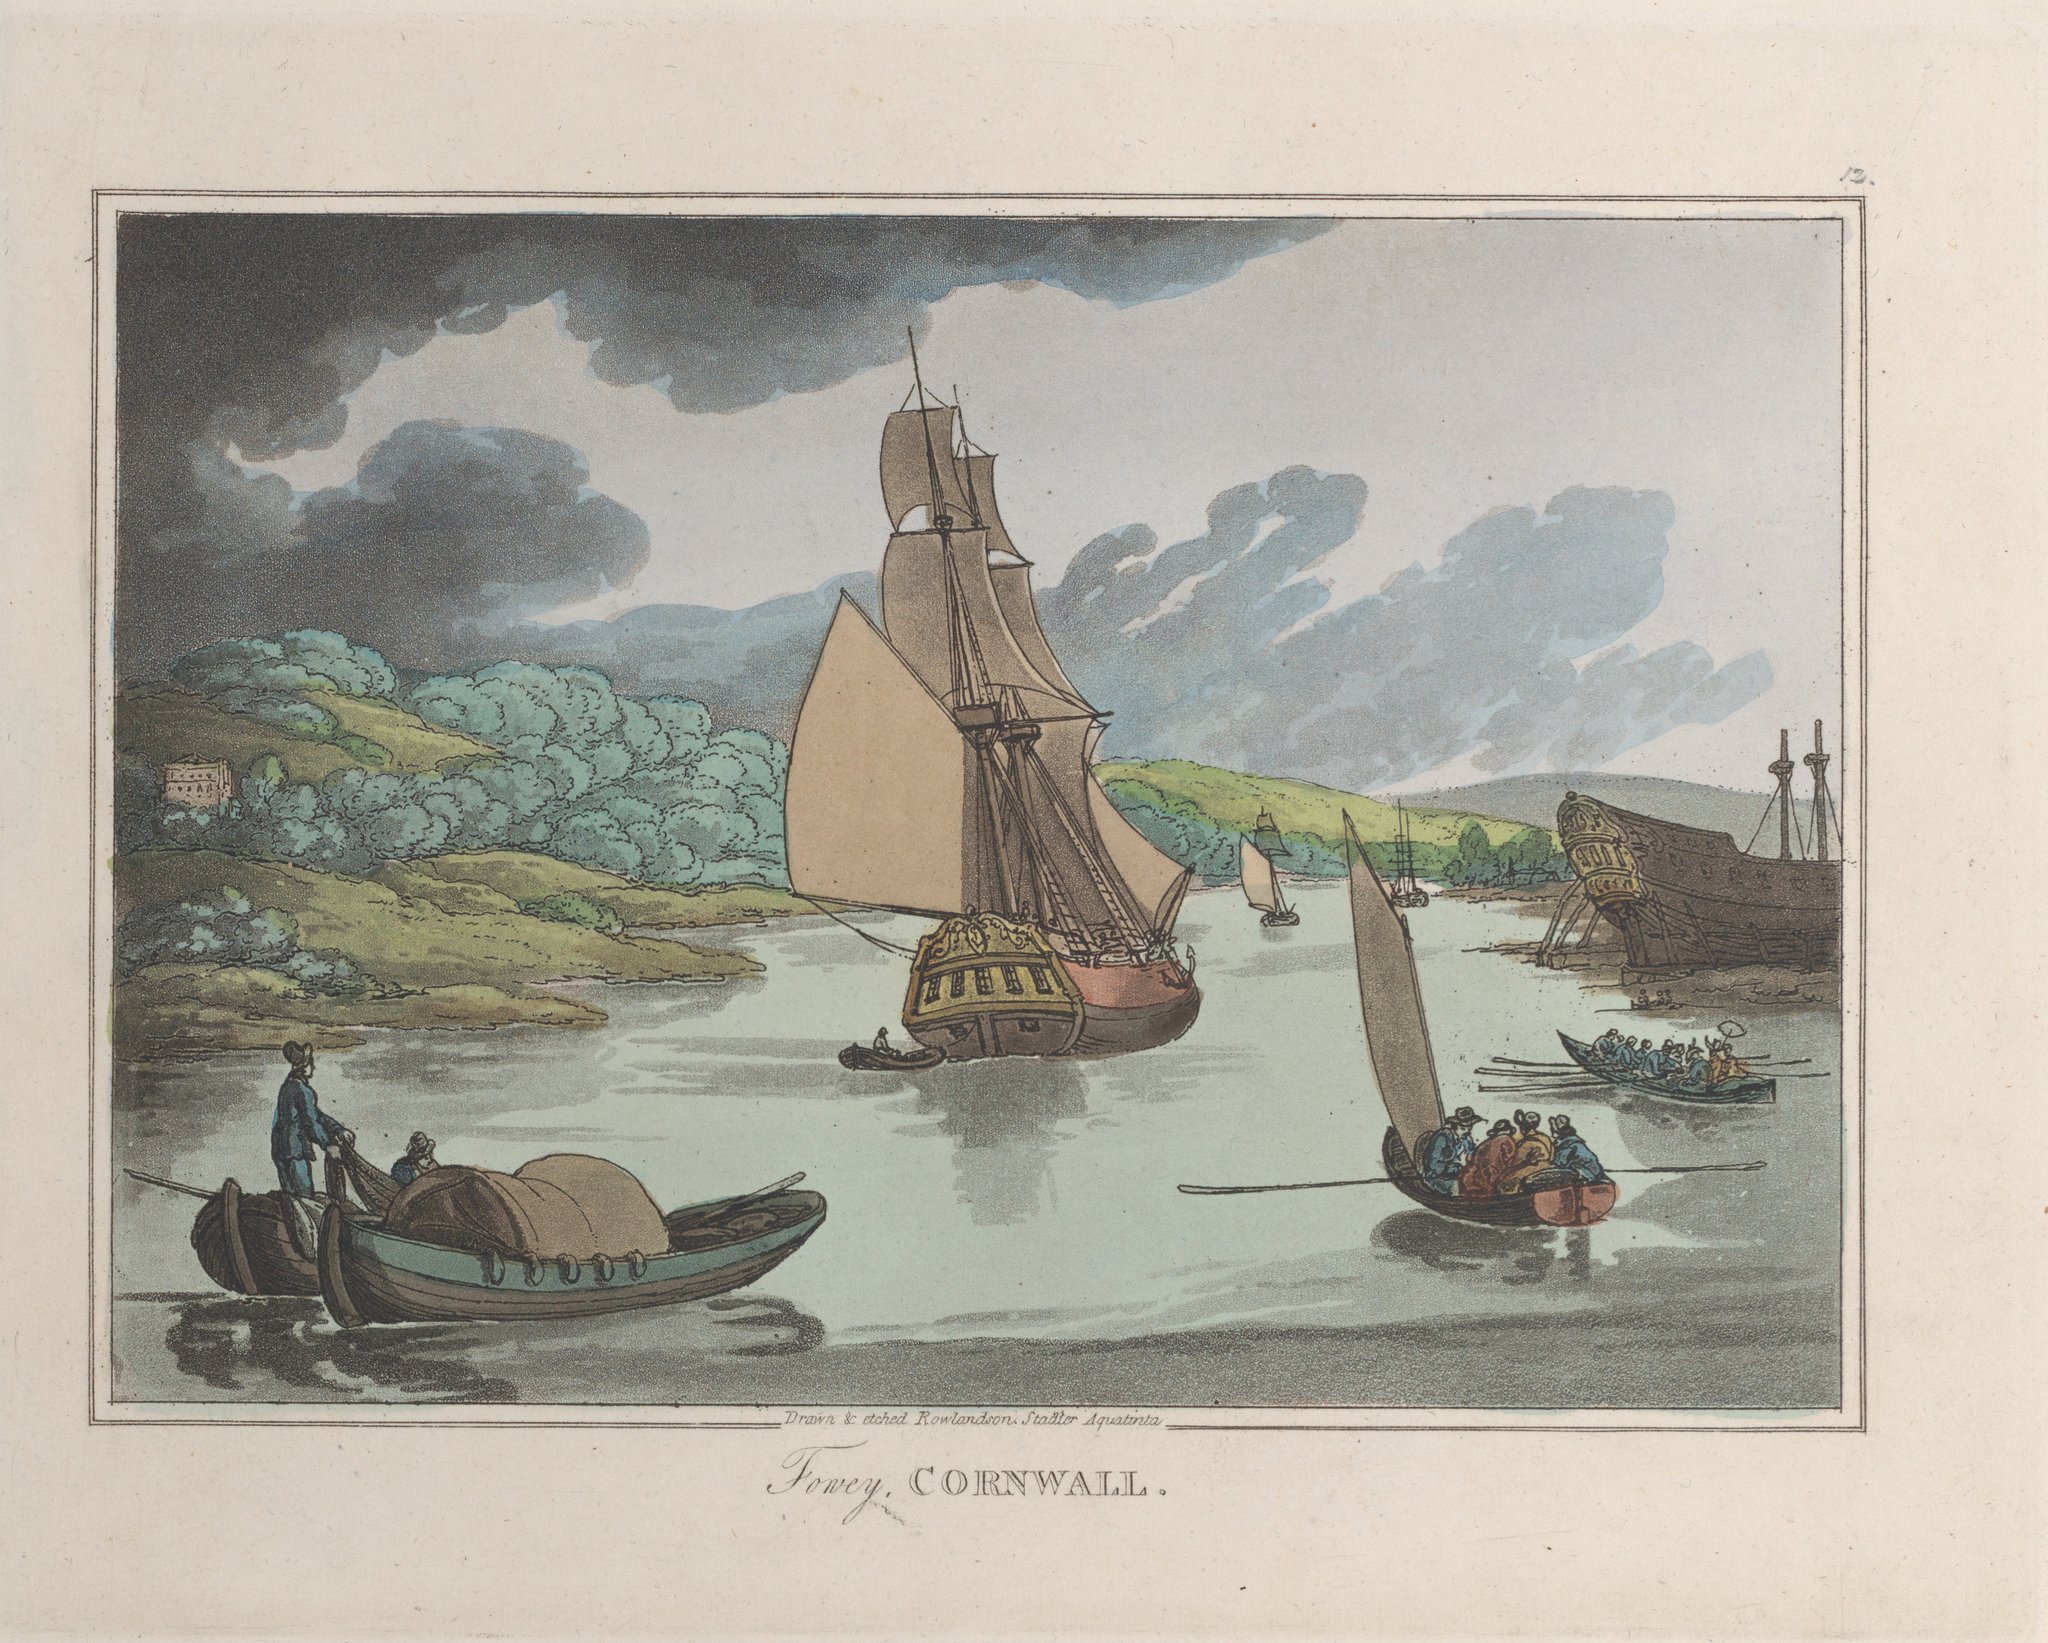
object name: print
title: Fowey, Cornwall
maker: thomas rowlandson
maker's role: artist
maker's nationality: british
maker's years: 1757-1827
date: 1822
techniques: aquatint, etching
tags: boats,ships